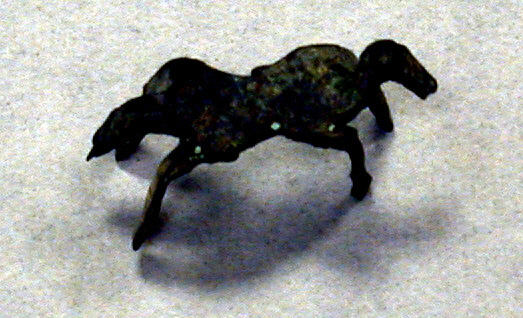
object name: figure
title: Zoomorphic Figure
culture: middle niger civilization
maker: middle niger artist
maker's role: artist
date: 1101-1600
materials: copper alloy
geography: mali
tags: animals